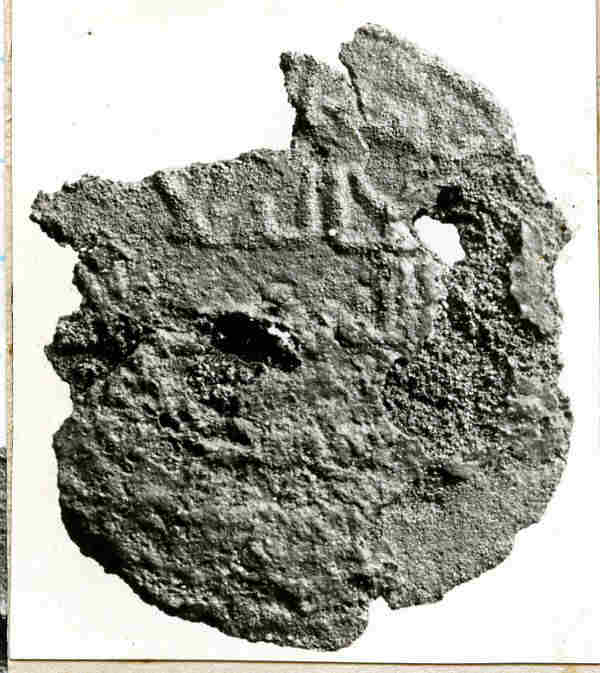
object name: coin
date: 701-900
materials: copper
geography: iran